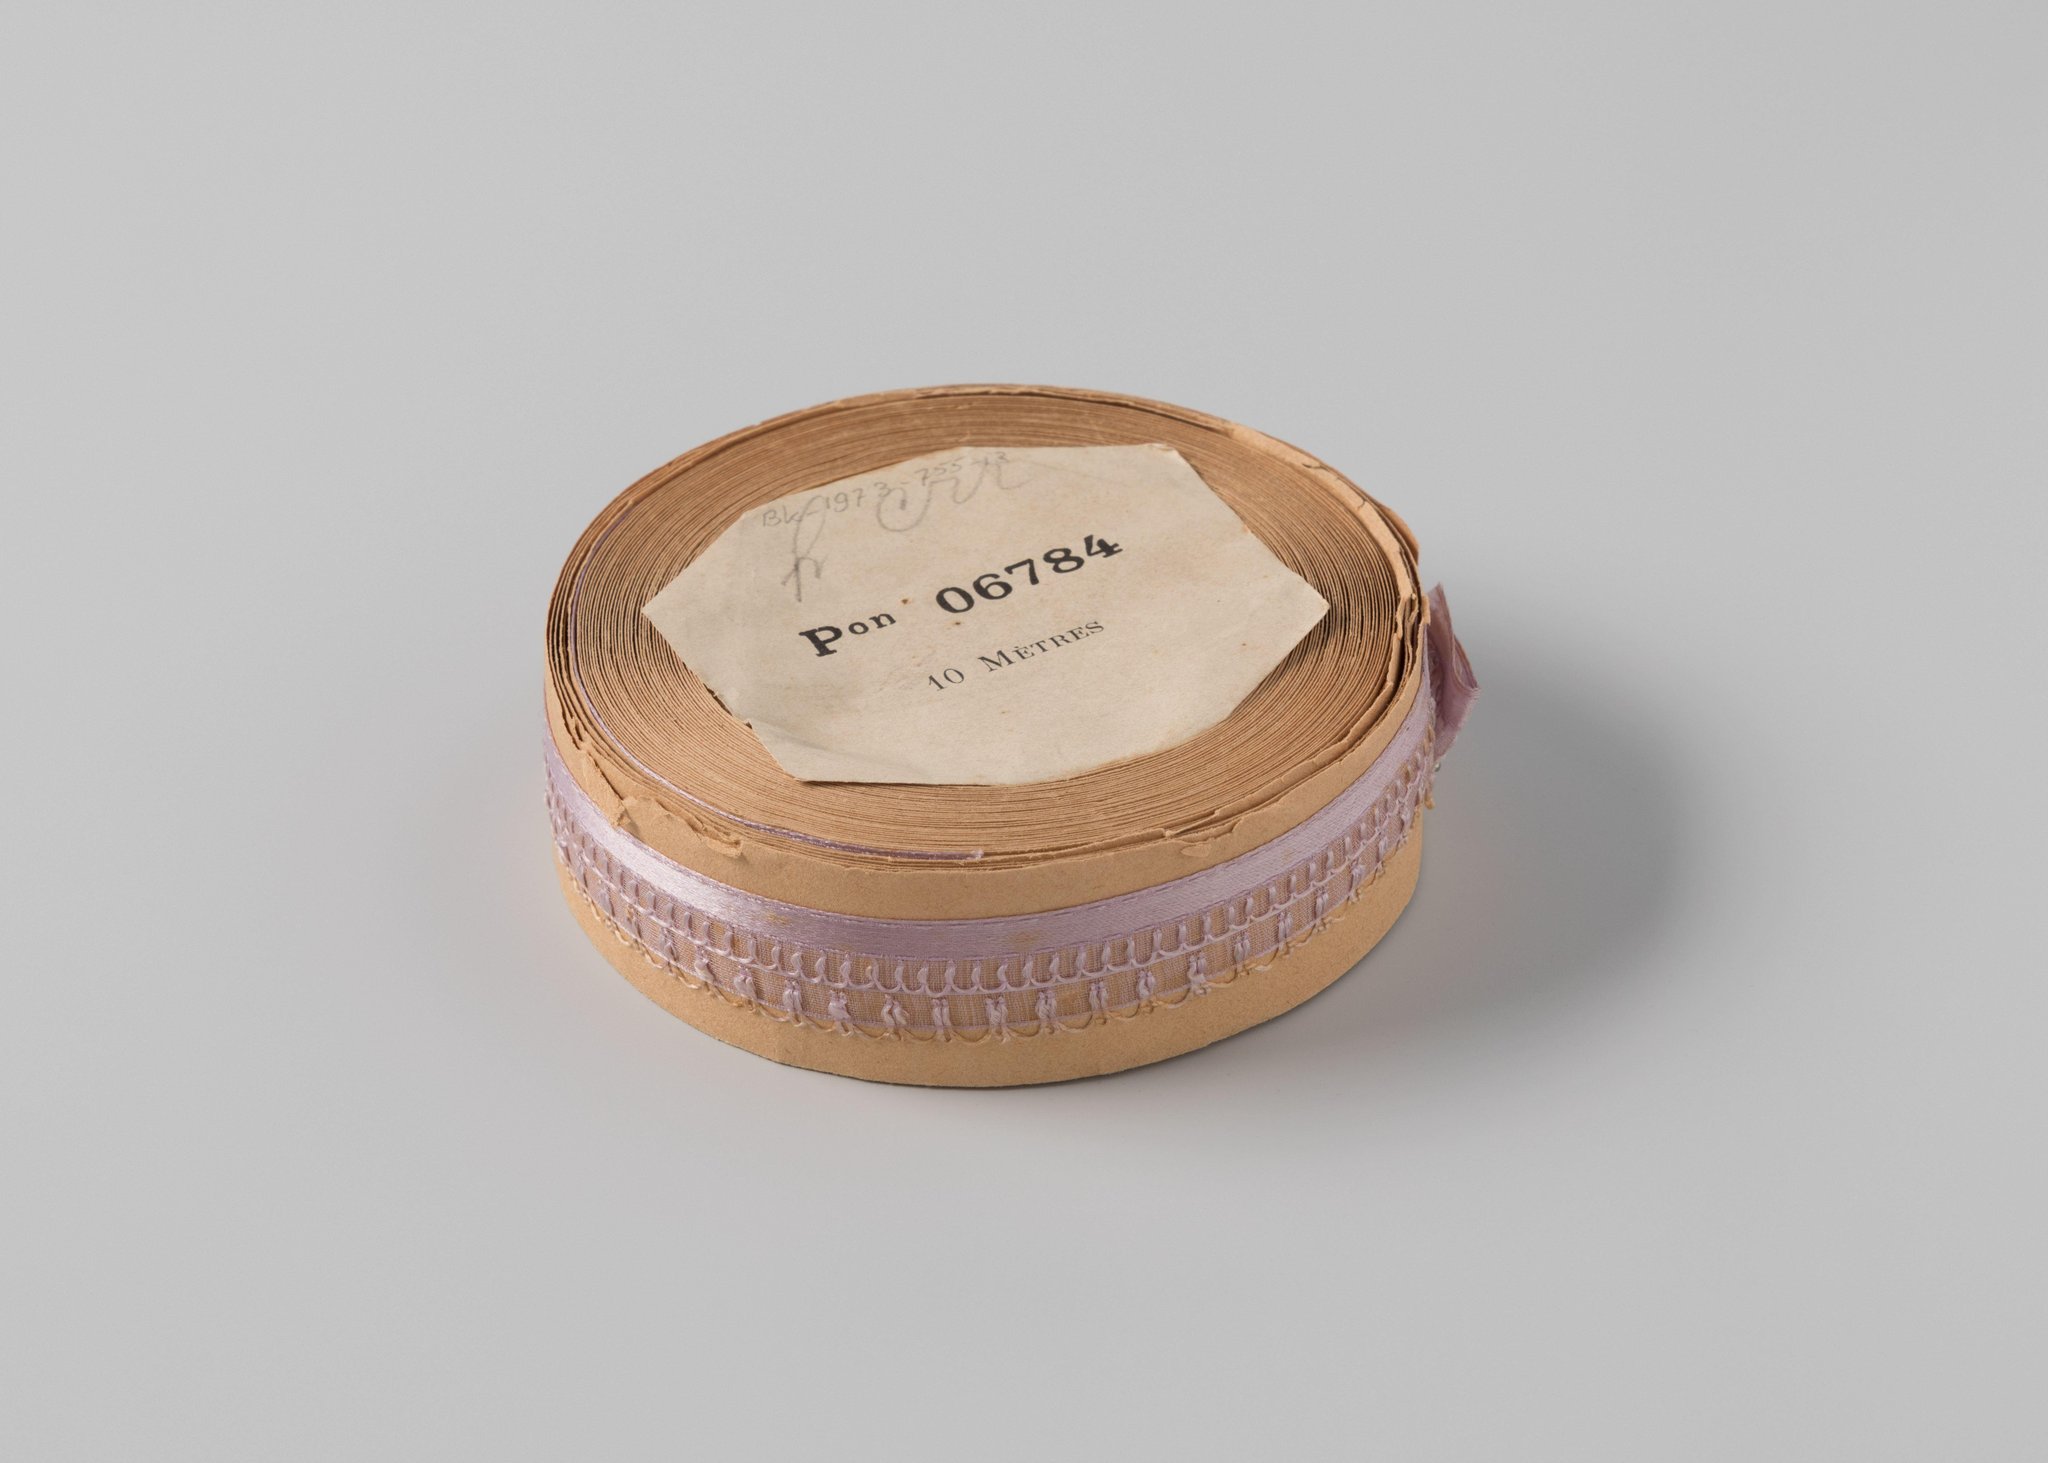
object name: braid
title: Lint op rol, lila gaaslint met twee rijen schulpen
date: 1890-1935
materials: cardboard, paper, textile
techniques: weave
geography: france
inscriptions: number: ‘Pon 06784’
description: Lint op rol, lila gaaslint met twee rijen schulpen.